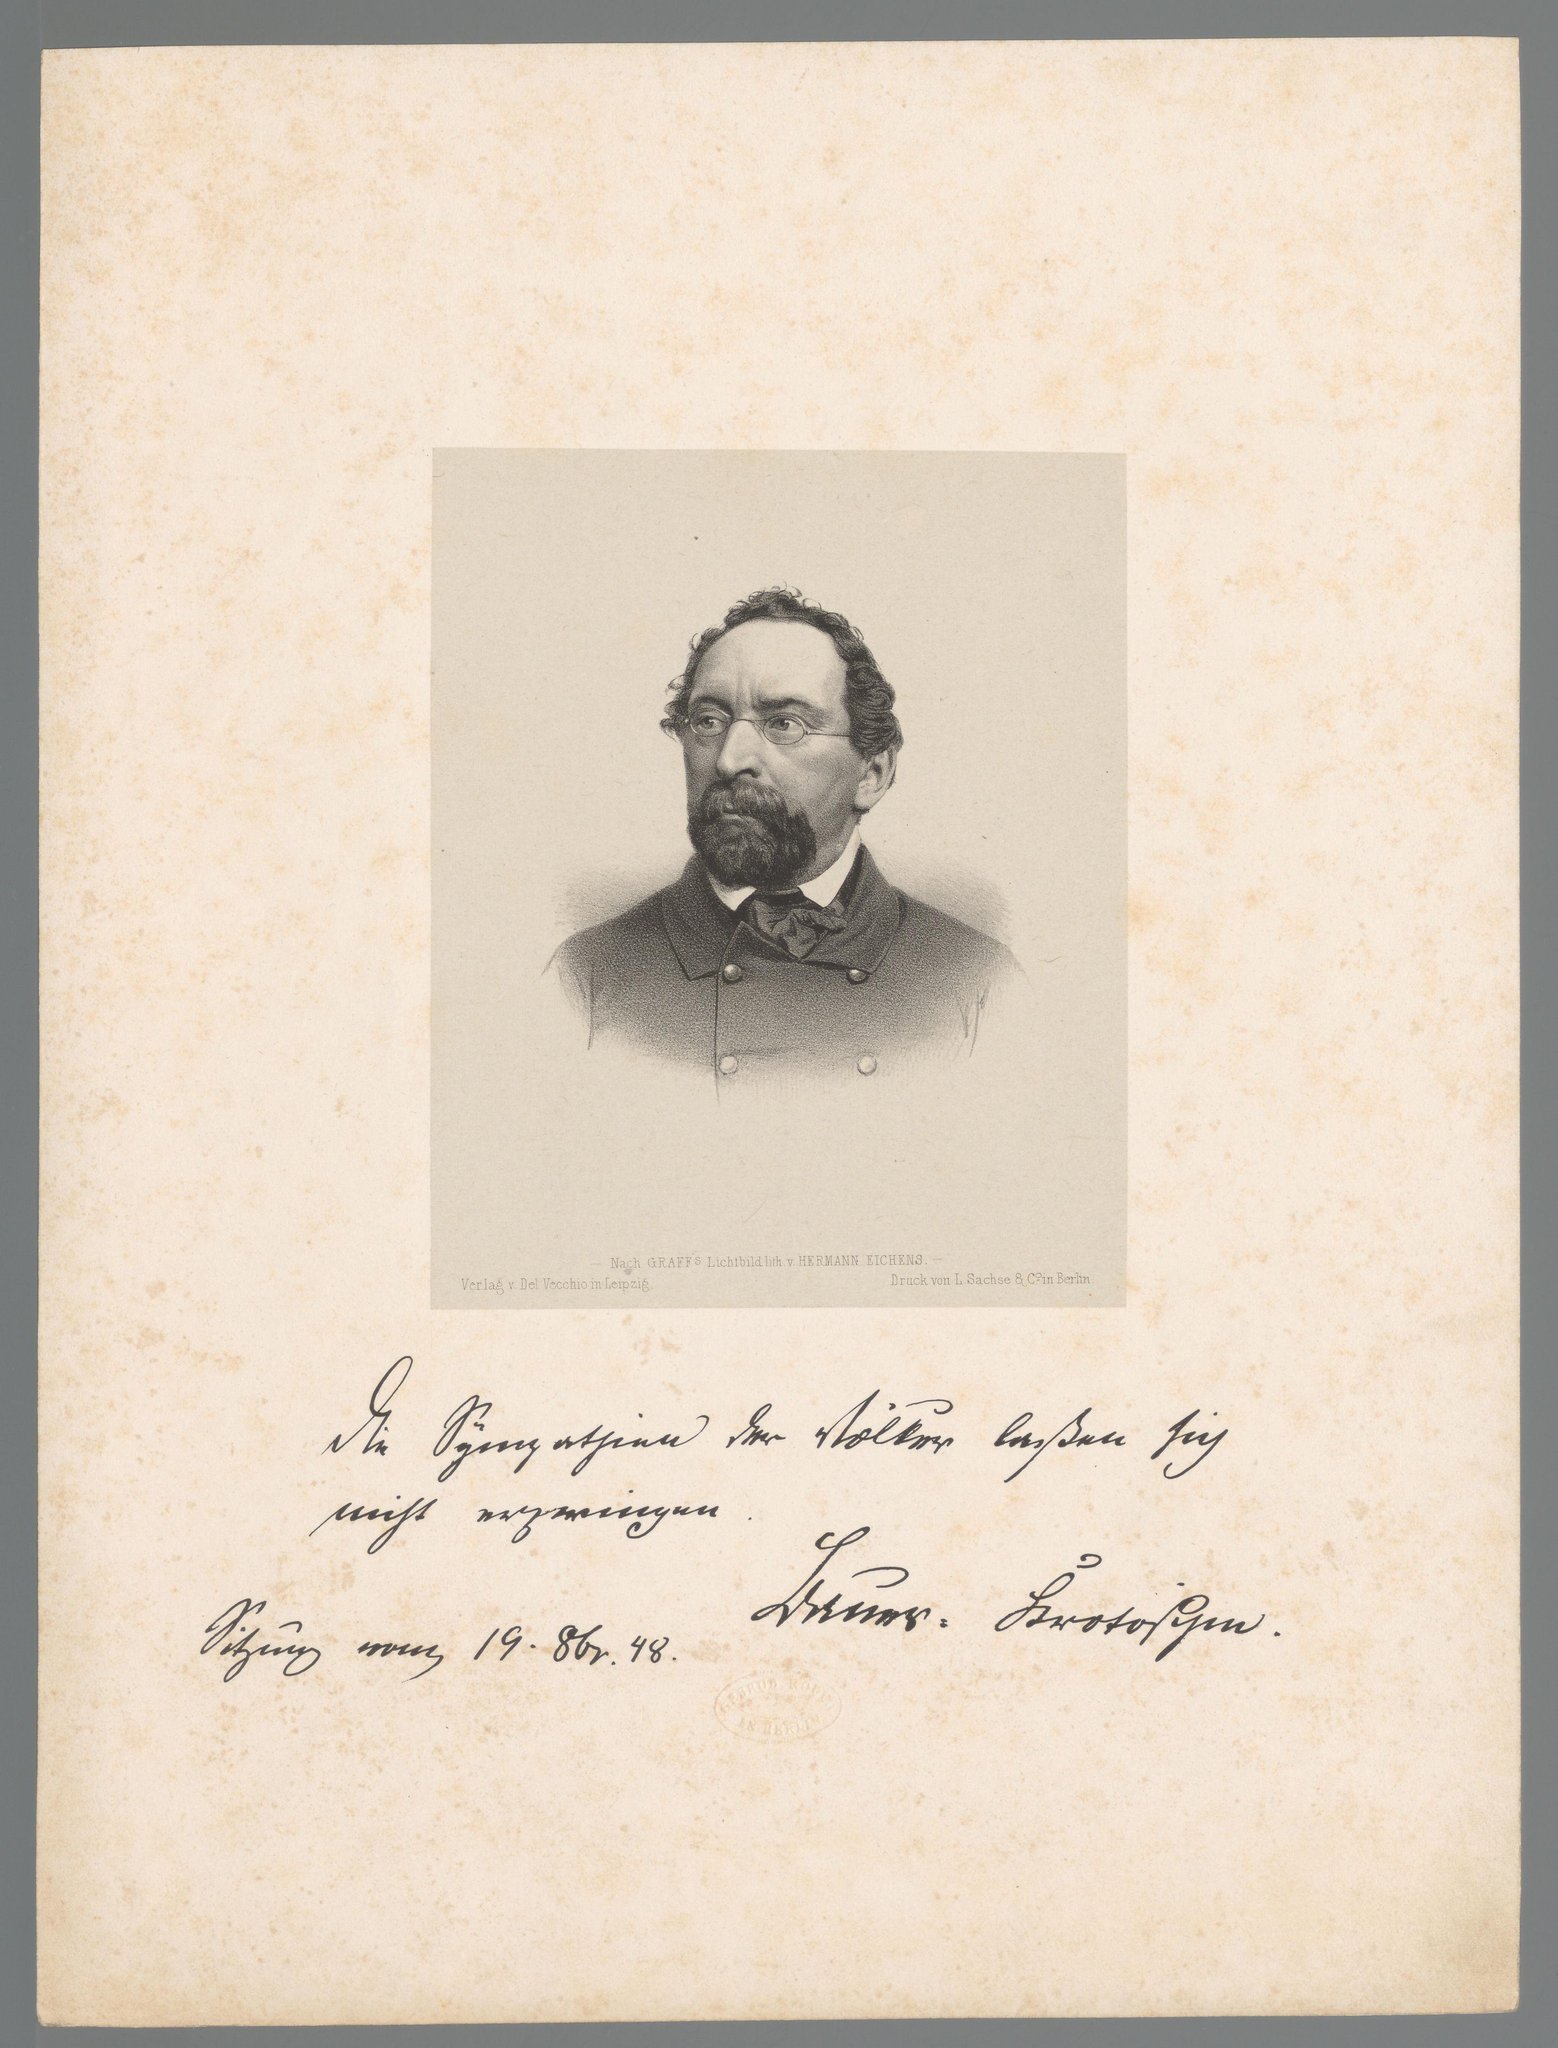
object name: print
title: Portret van een onbekende man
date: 1870-1886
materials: paper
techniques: lithograph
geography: berlin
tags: historical persons not known by name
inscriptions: collector's mark: Lugt 2228, check stamp: Lugt 2141c